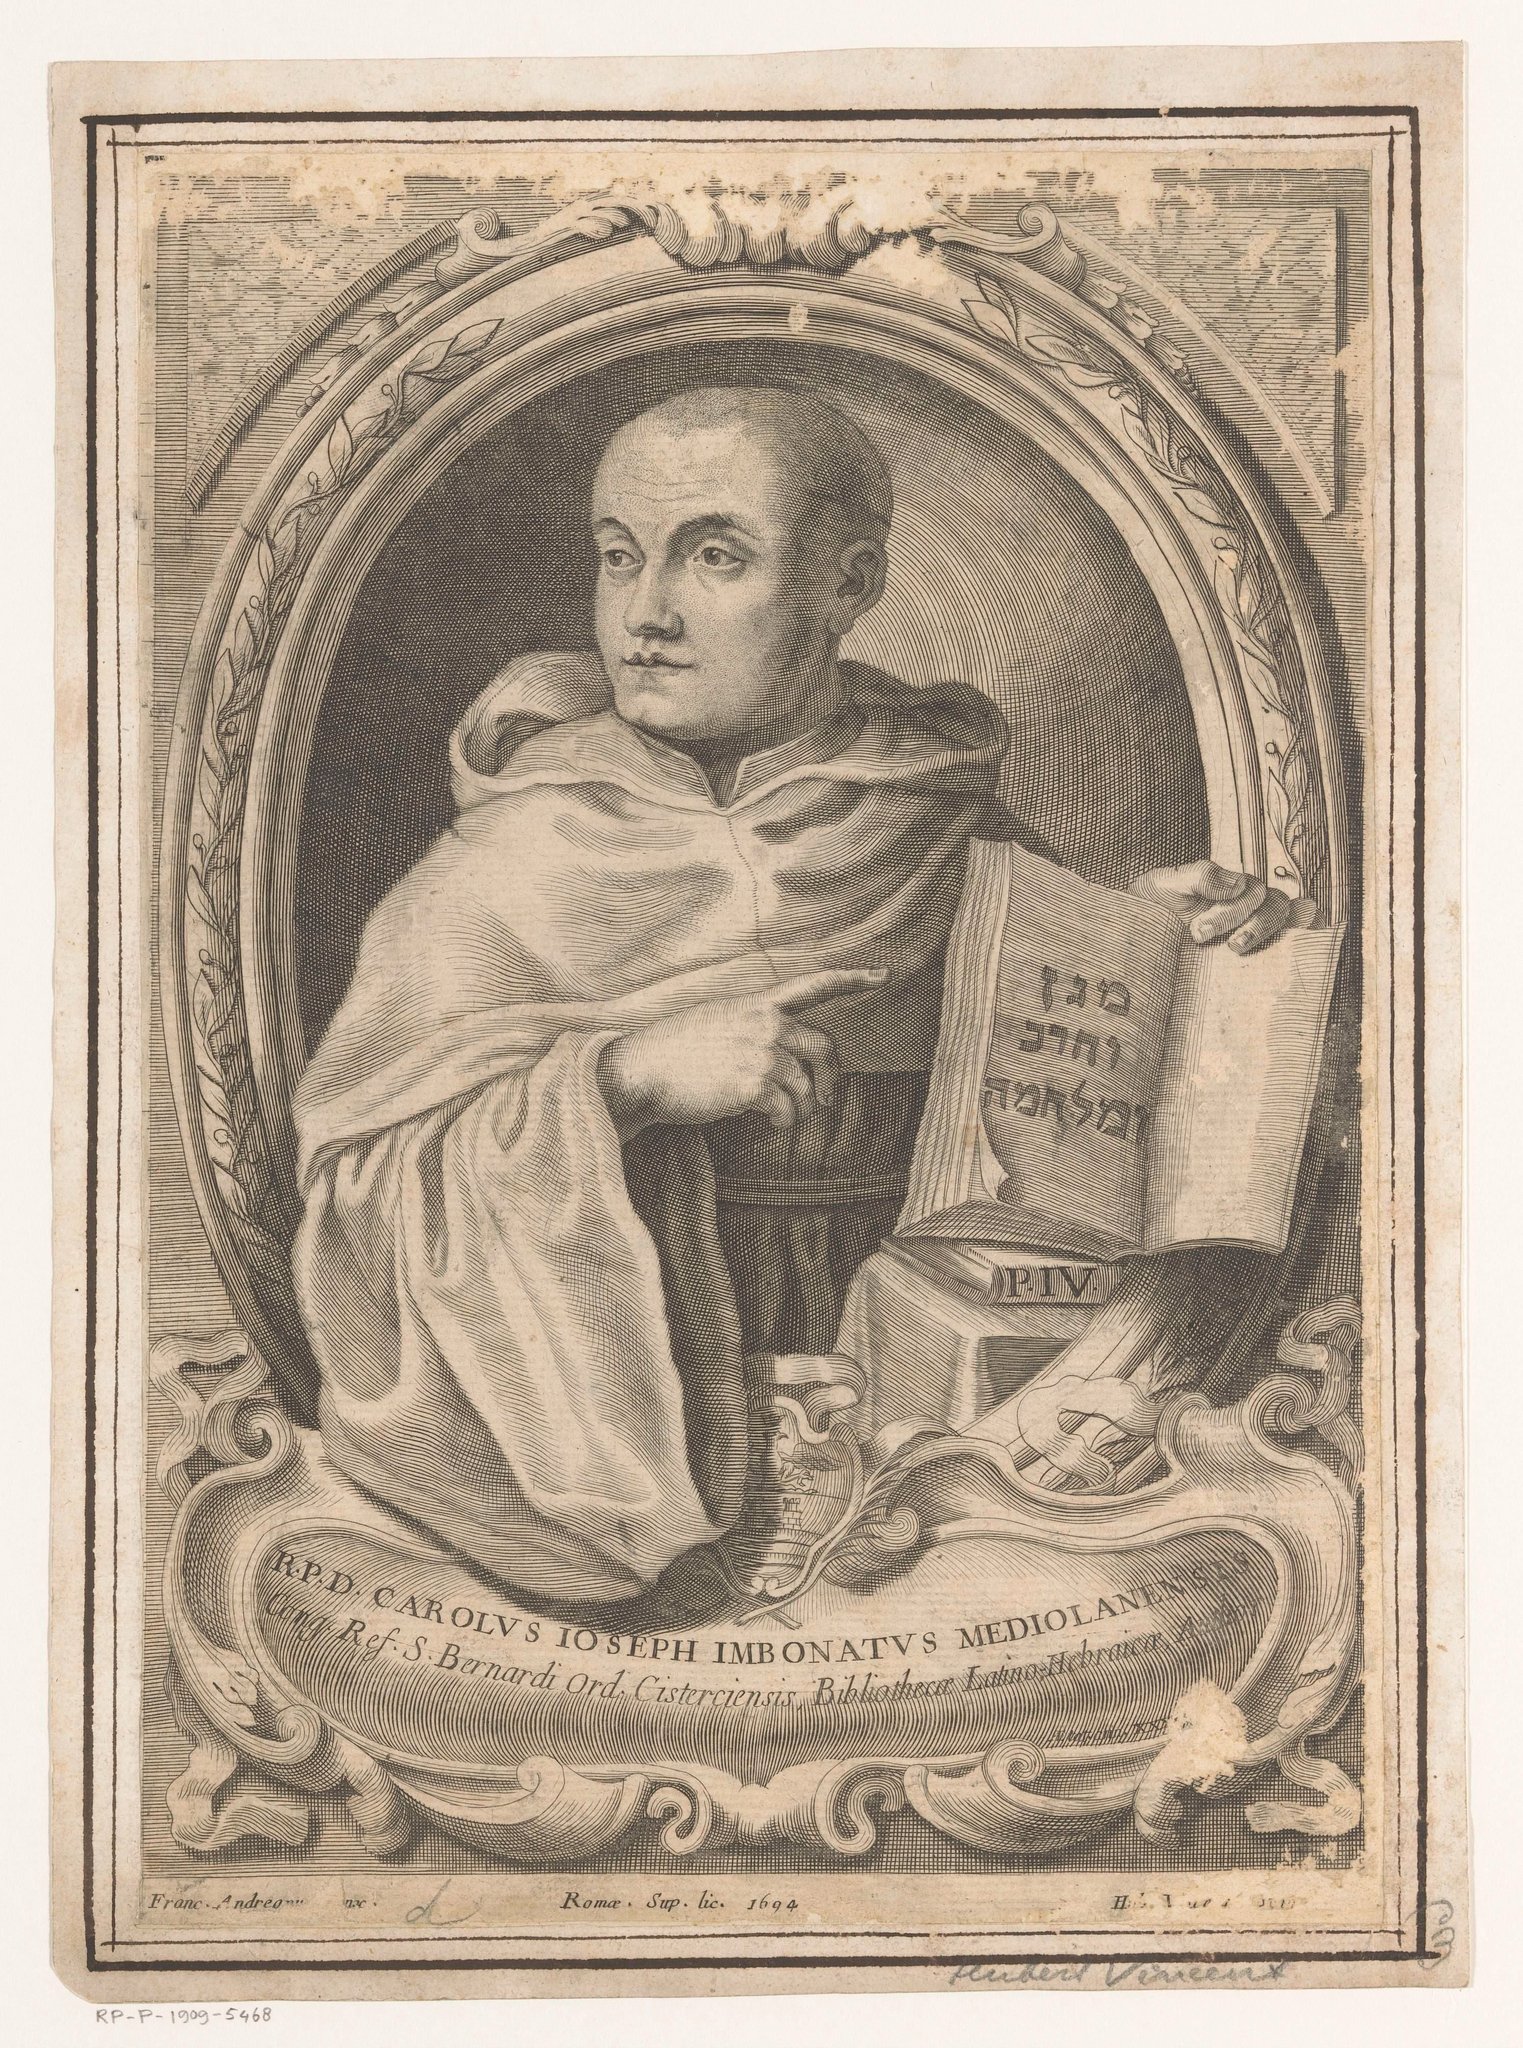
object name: titelblad, titelpagina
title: Portret van Carlo Giuseppe Imbonati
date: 1694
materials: ink, paper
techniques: engraving, etching, pen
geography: rome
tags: hebrew script, theologian, historical persons, monastic orders, monastic life: cistercians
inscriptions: collector's mark: Lugt 2228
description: Titelpagina voor: Imbonati, Carlo Giuseppe. Bibliotheca Latino-Hebraica, sive de Scriptoribus latinis, qui ex diversis nationibus contra Judaeos vel de re hebraica utcumque scripsere (...). Rome: Sacra Congregatio de Propaganda Fide, 1694.